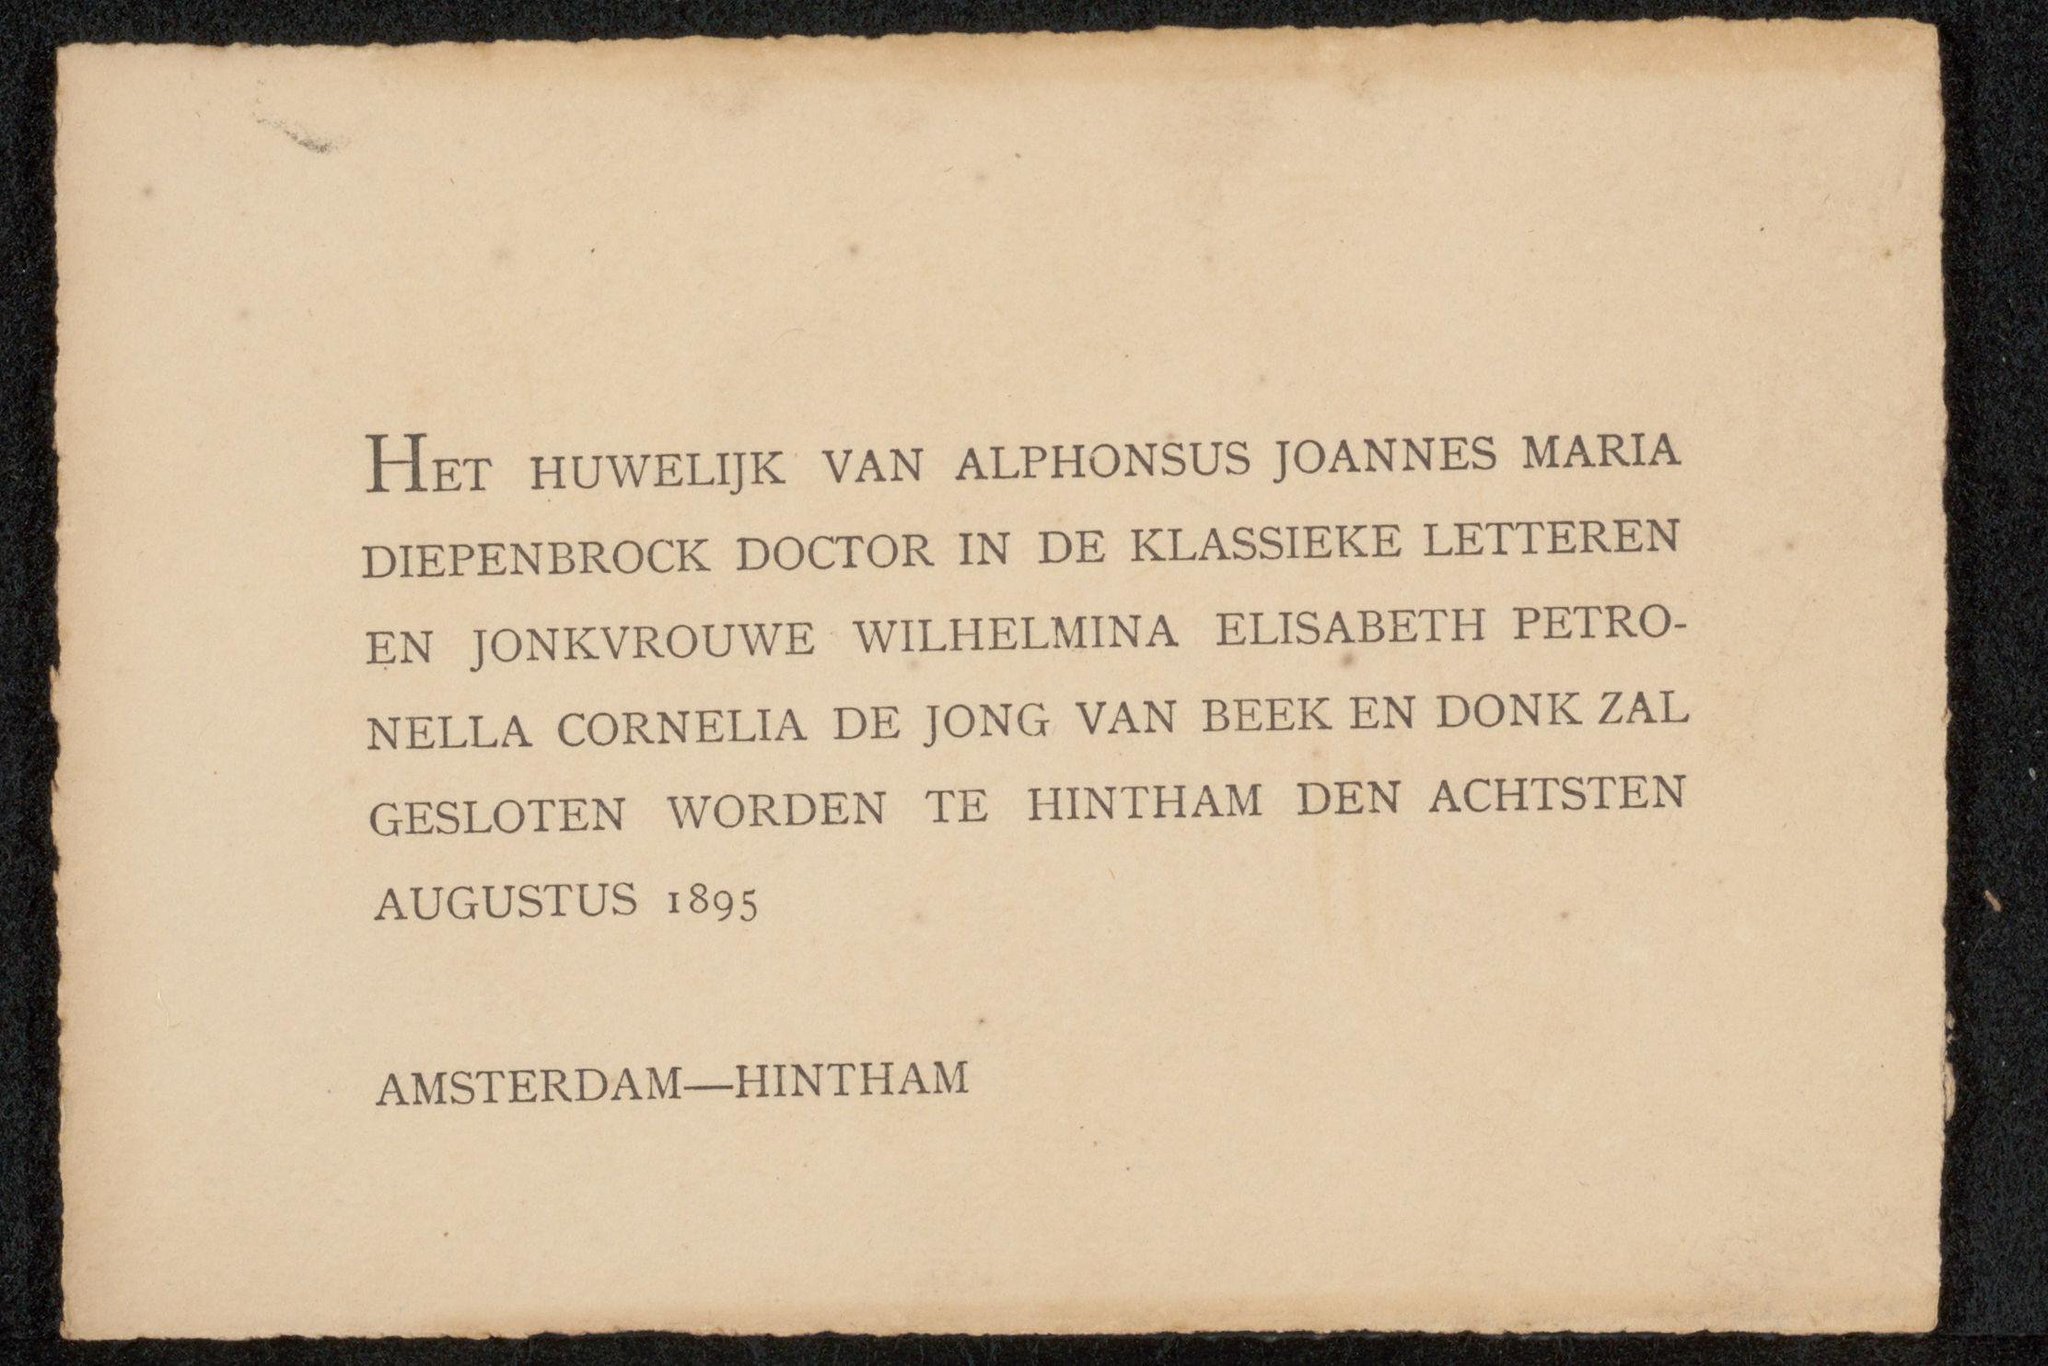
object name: wedding announcement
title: Huwelijksaankondiging aan Philip Zilcken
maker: Anonymous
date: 1895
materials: cardboard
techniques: printing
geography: amsterdam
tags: alphons diepenbrock, jonkvrouw wilhelmina elisabeth petronella cornelia de jong van beek en donk, the hague, painter, draughtsman, philip zilcken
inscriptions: collector's mark: ‘RPK’